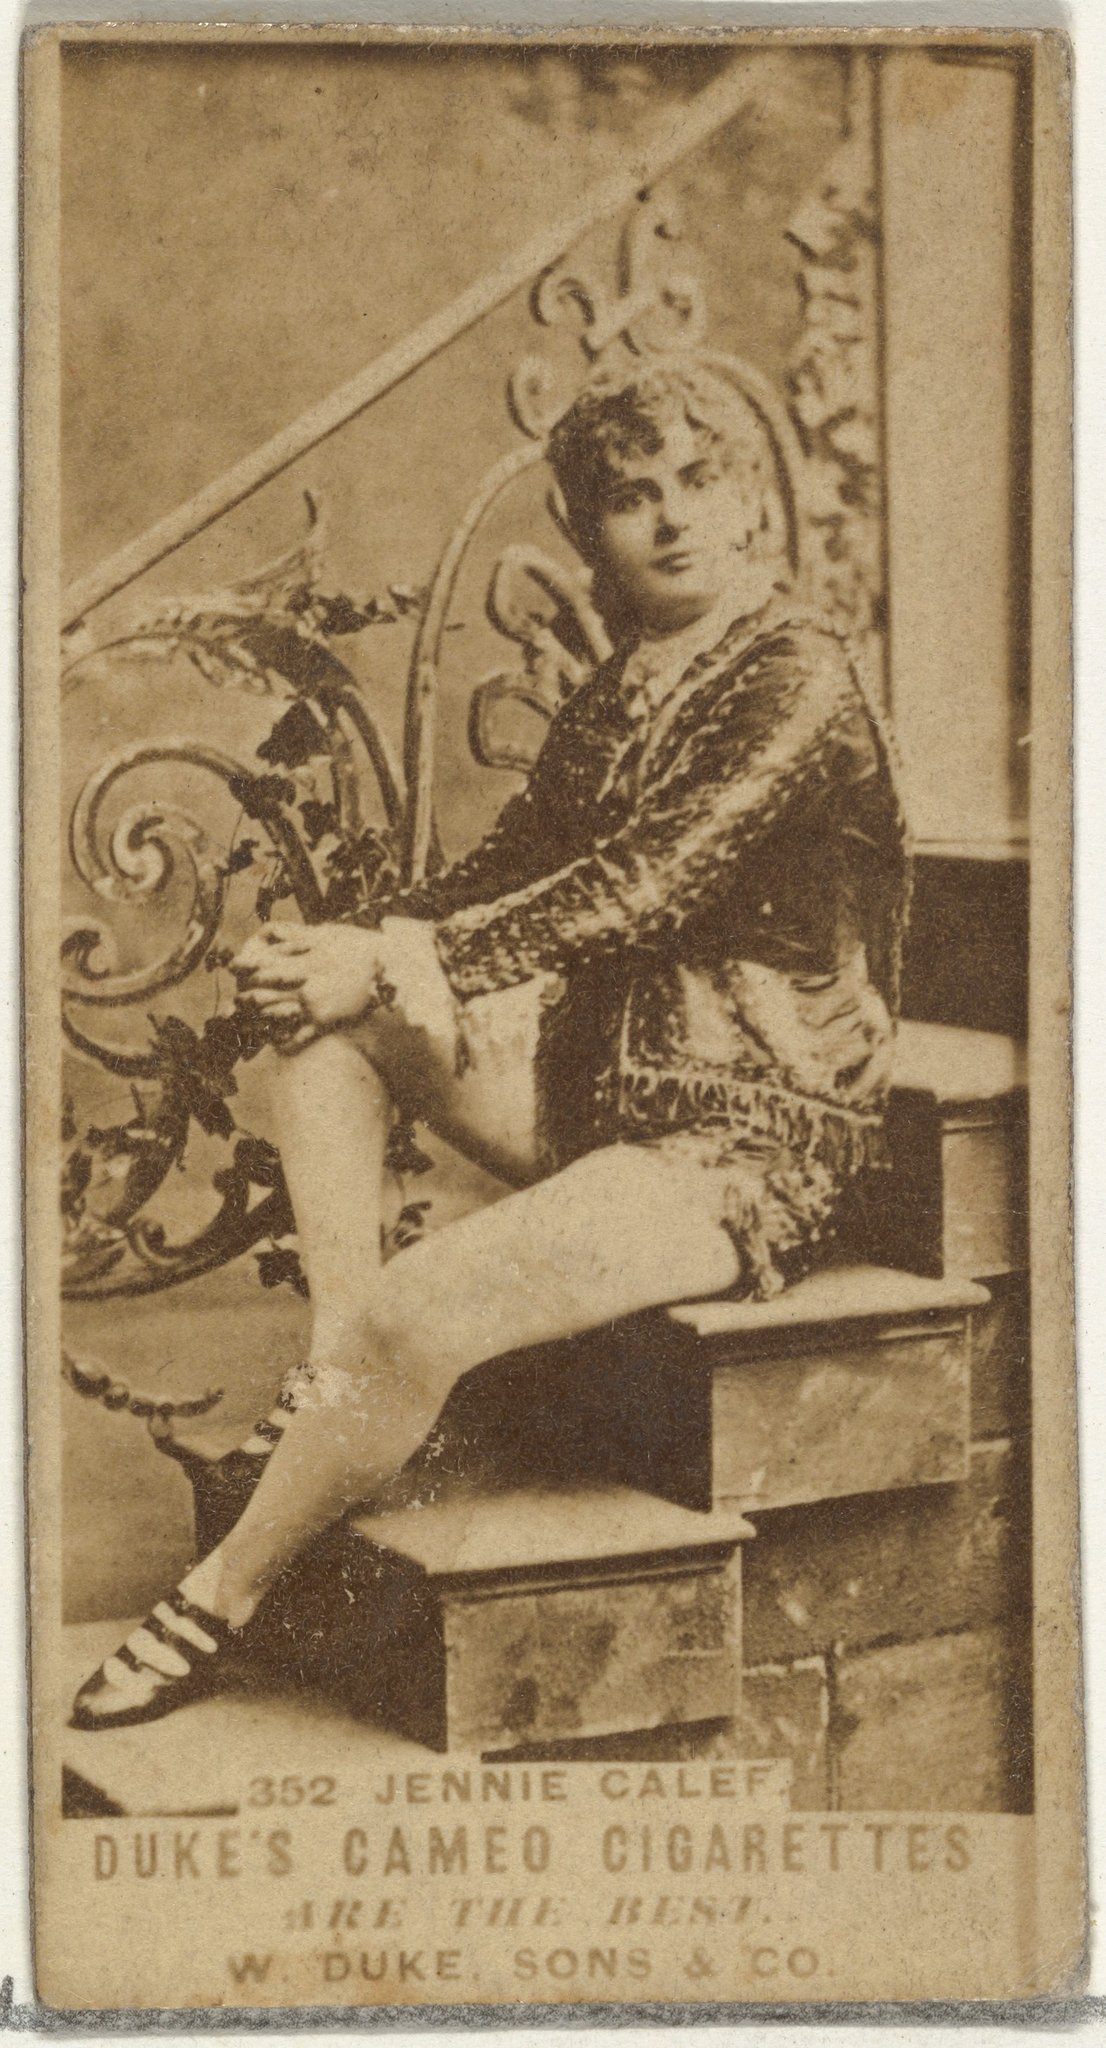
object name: photograph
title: Card Number 352, Jennie Calef, from the Actors and Actresses series (N145-5) issued by Duke Sons & Co. to promote Cameo Cigarettes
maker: w. duke, sons & co.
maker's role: publisher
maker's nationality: american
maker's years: 1870-1920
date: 1880-1889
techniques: albumen silver print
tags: portraits,women,actresses